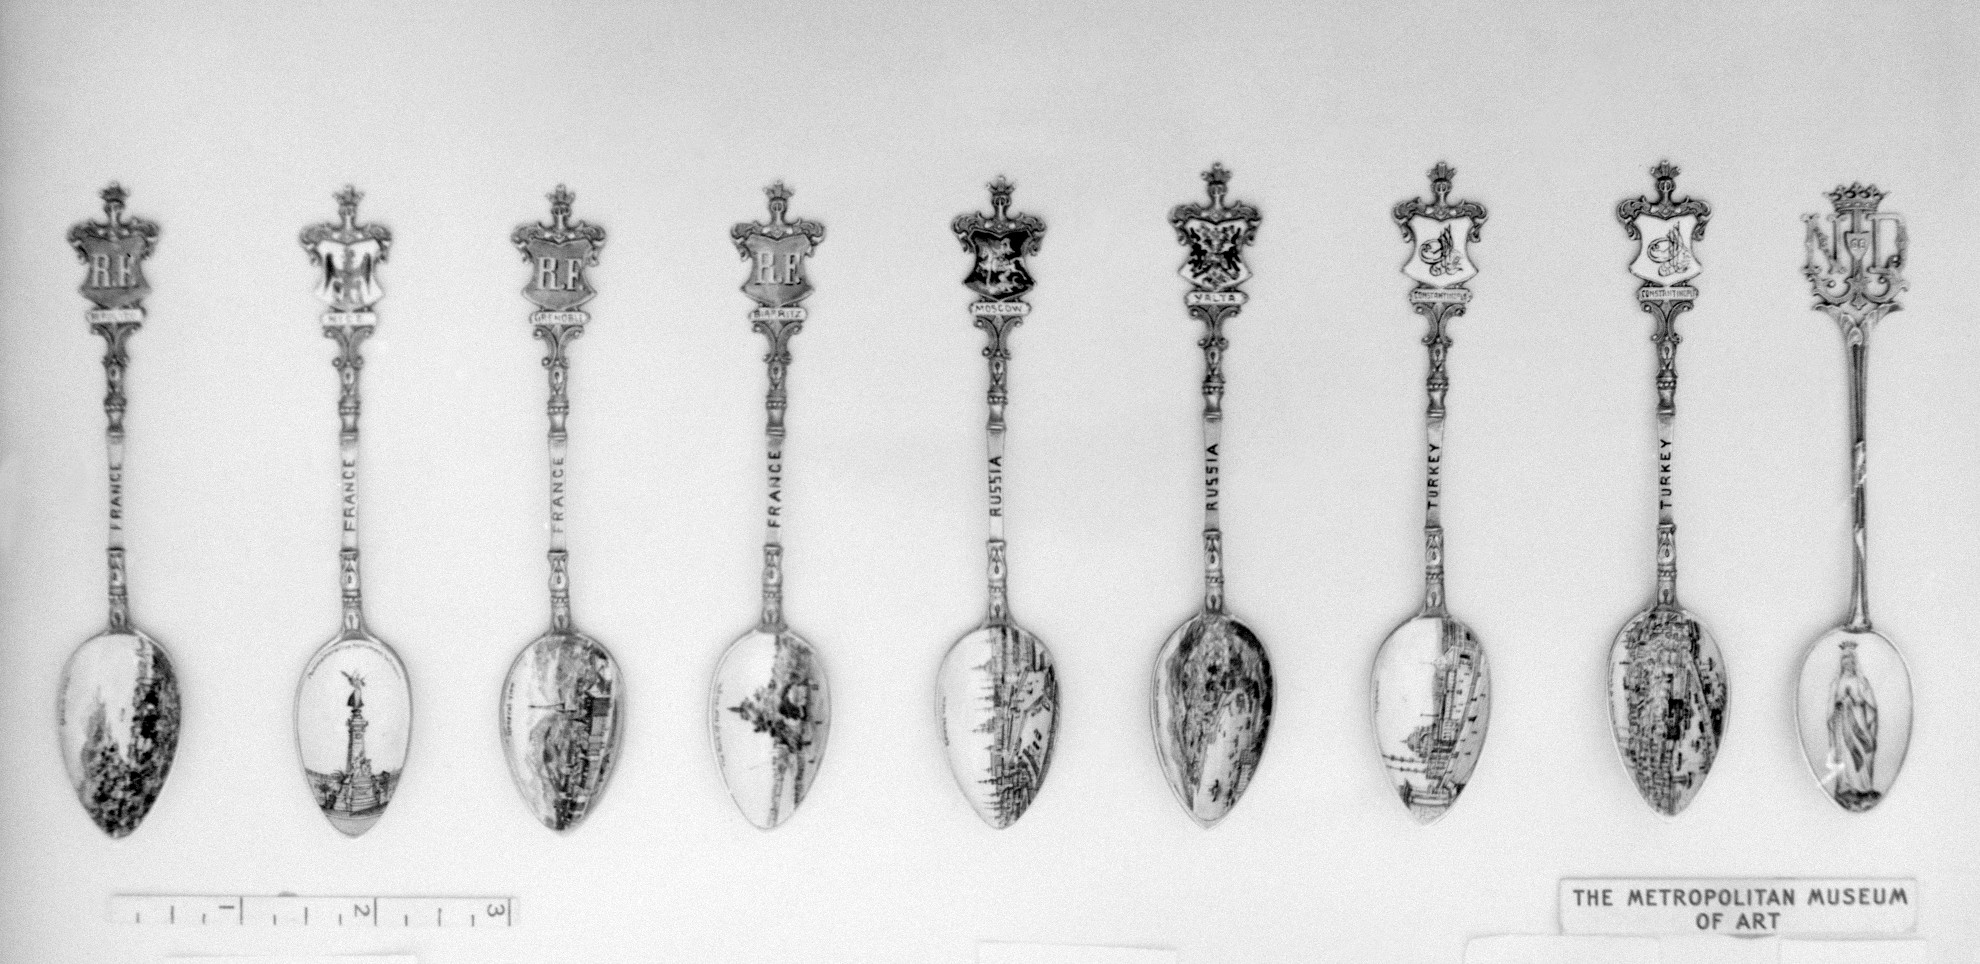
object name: souvenir spoon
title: Souvenir spoon with view of Moscow and the river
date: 1867-1900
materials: enamel, gilt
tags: coat of arms